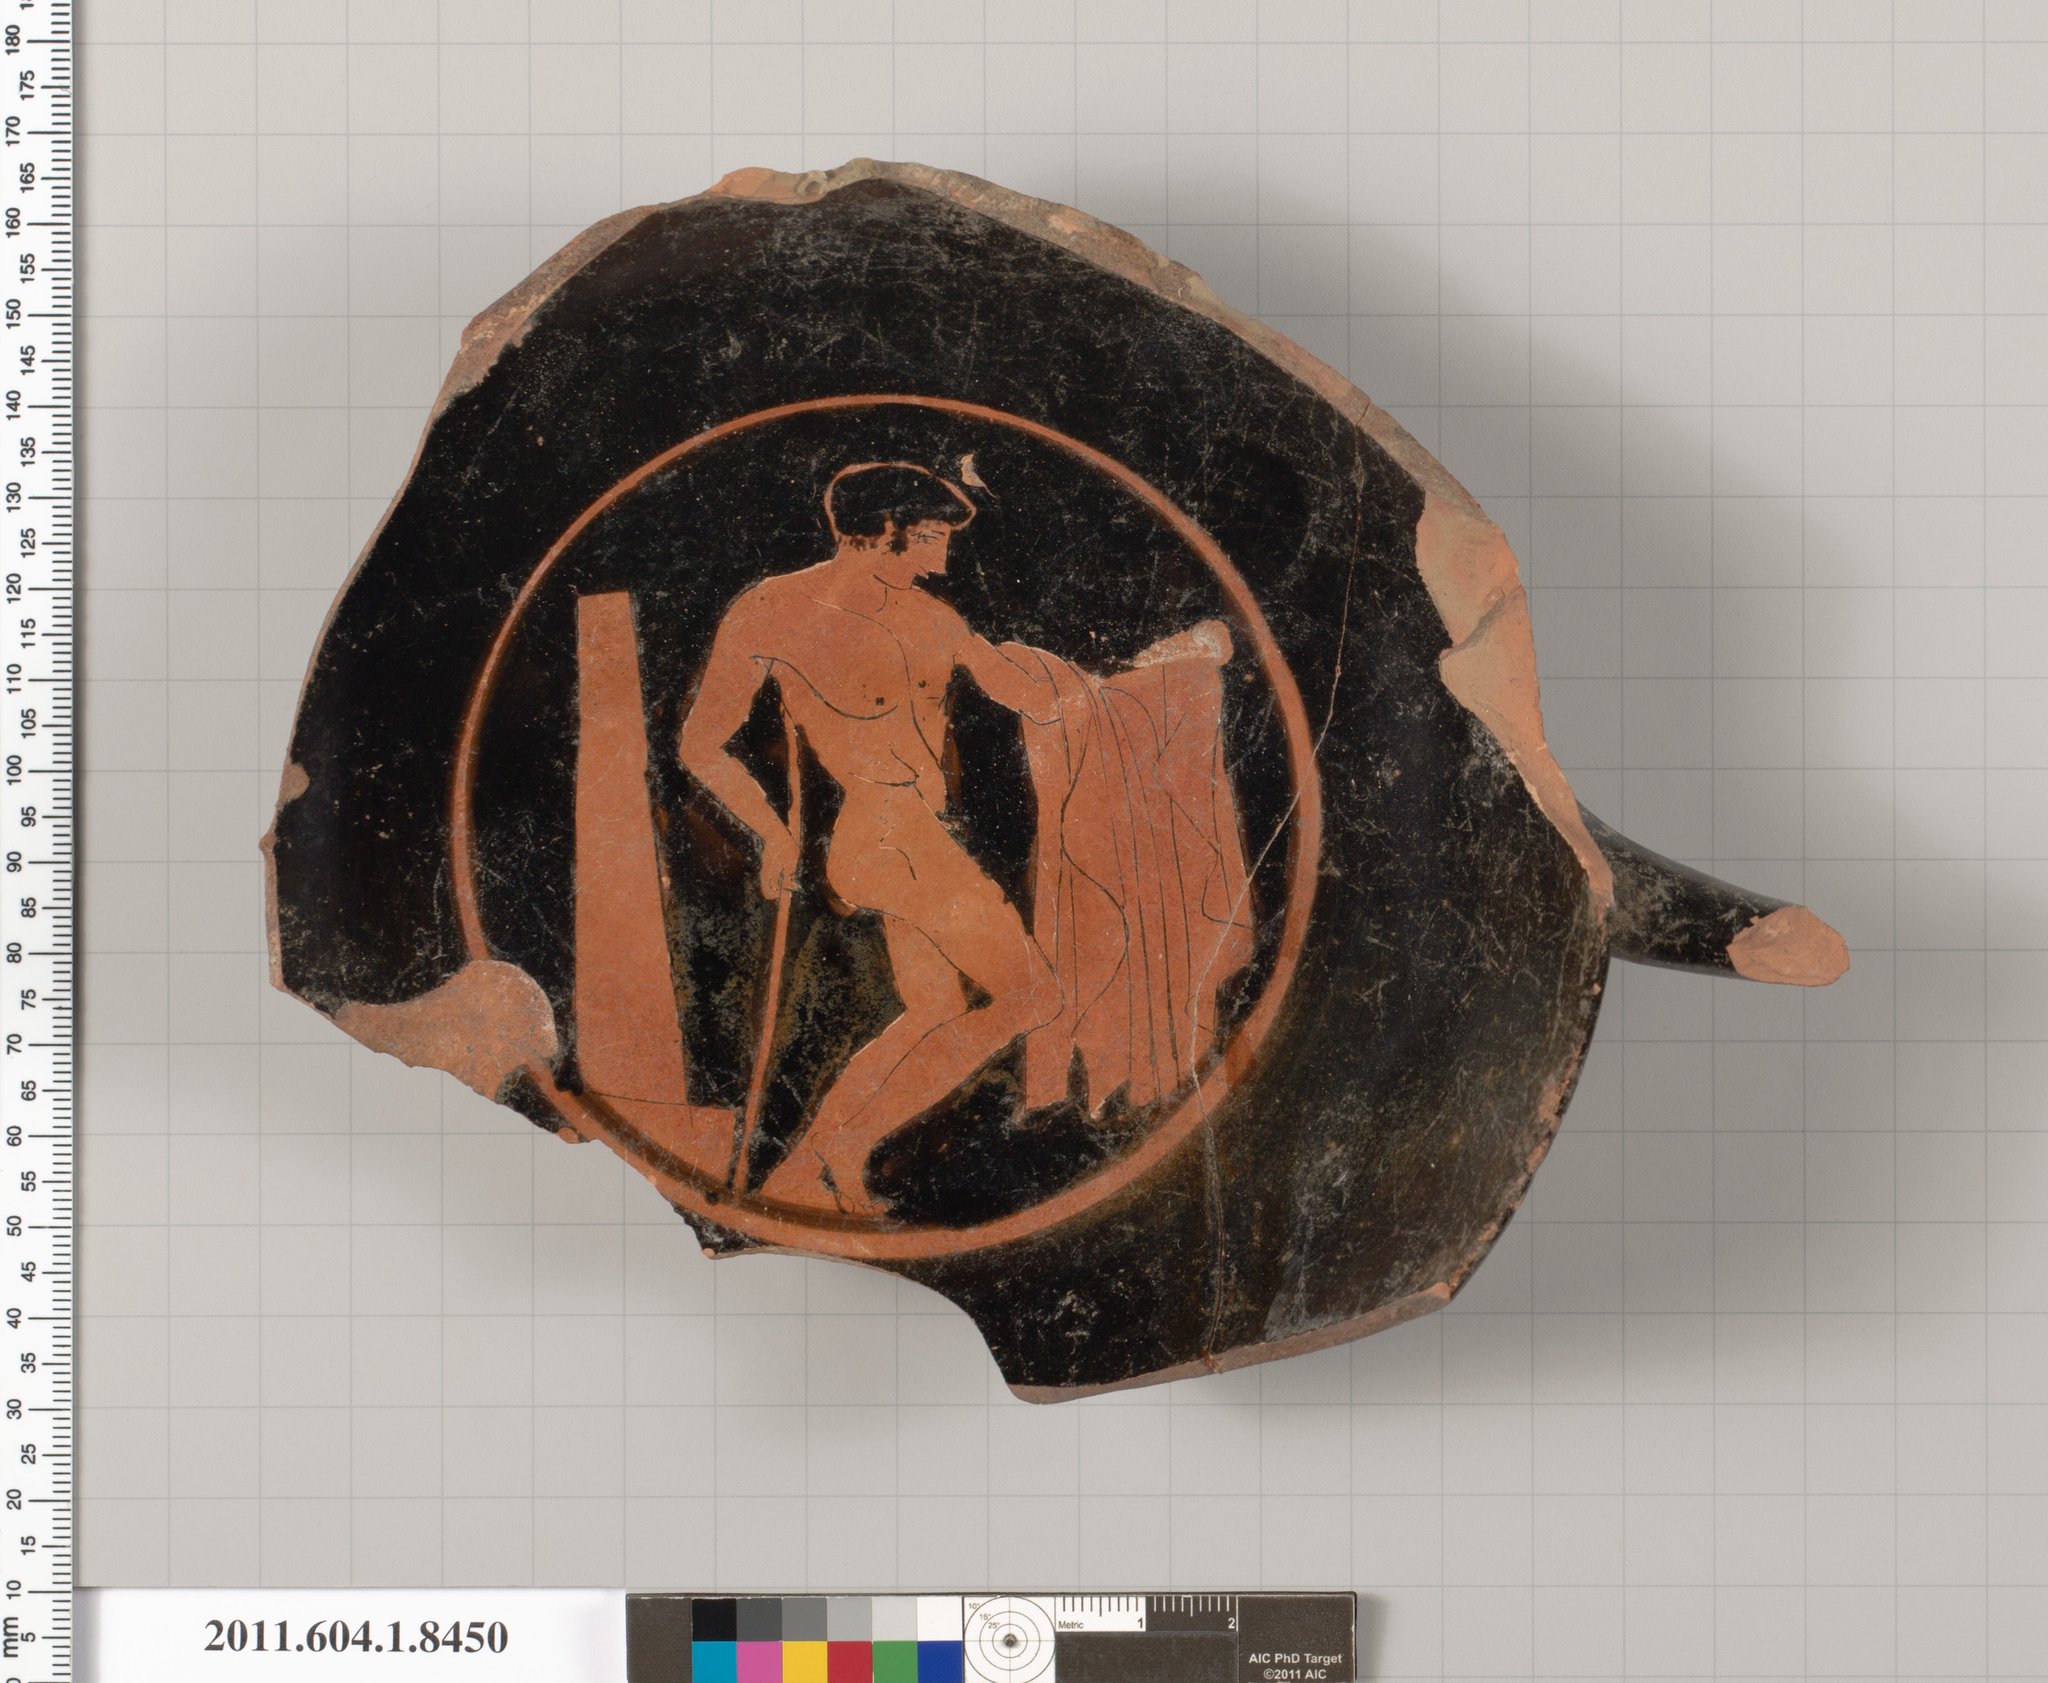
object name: kylix fragment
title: Terracotta fragment of a stemless kylix (drinking cup)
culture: greek, attic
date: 460-450 BCE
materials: terracotta